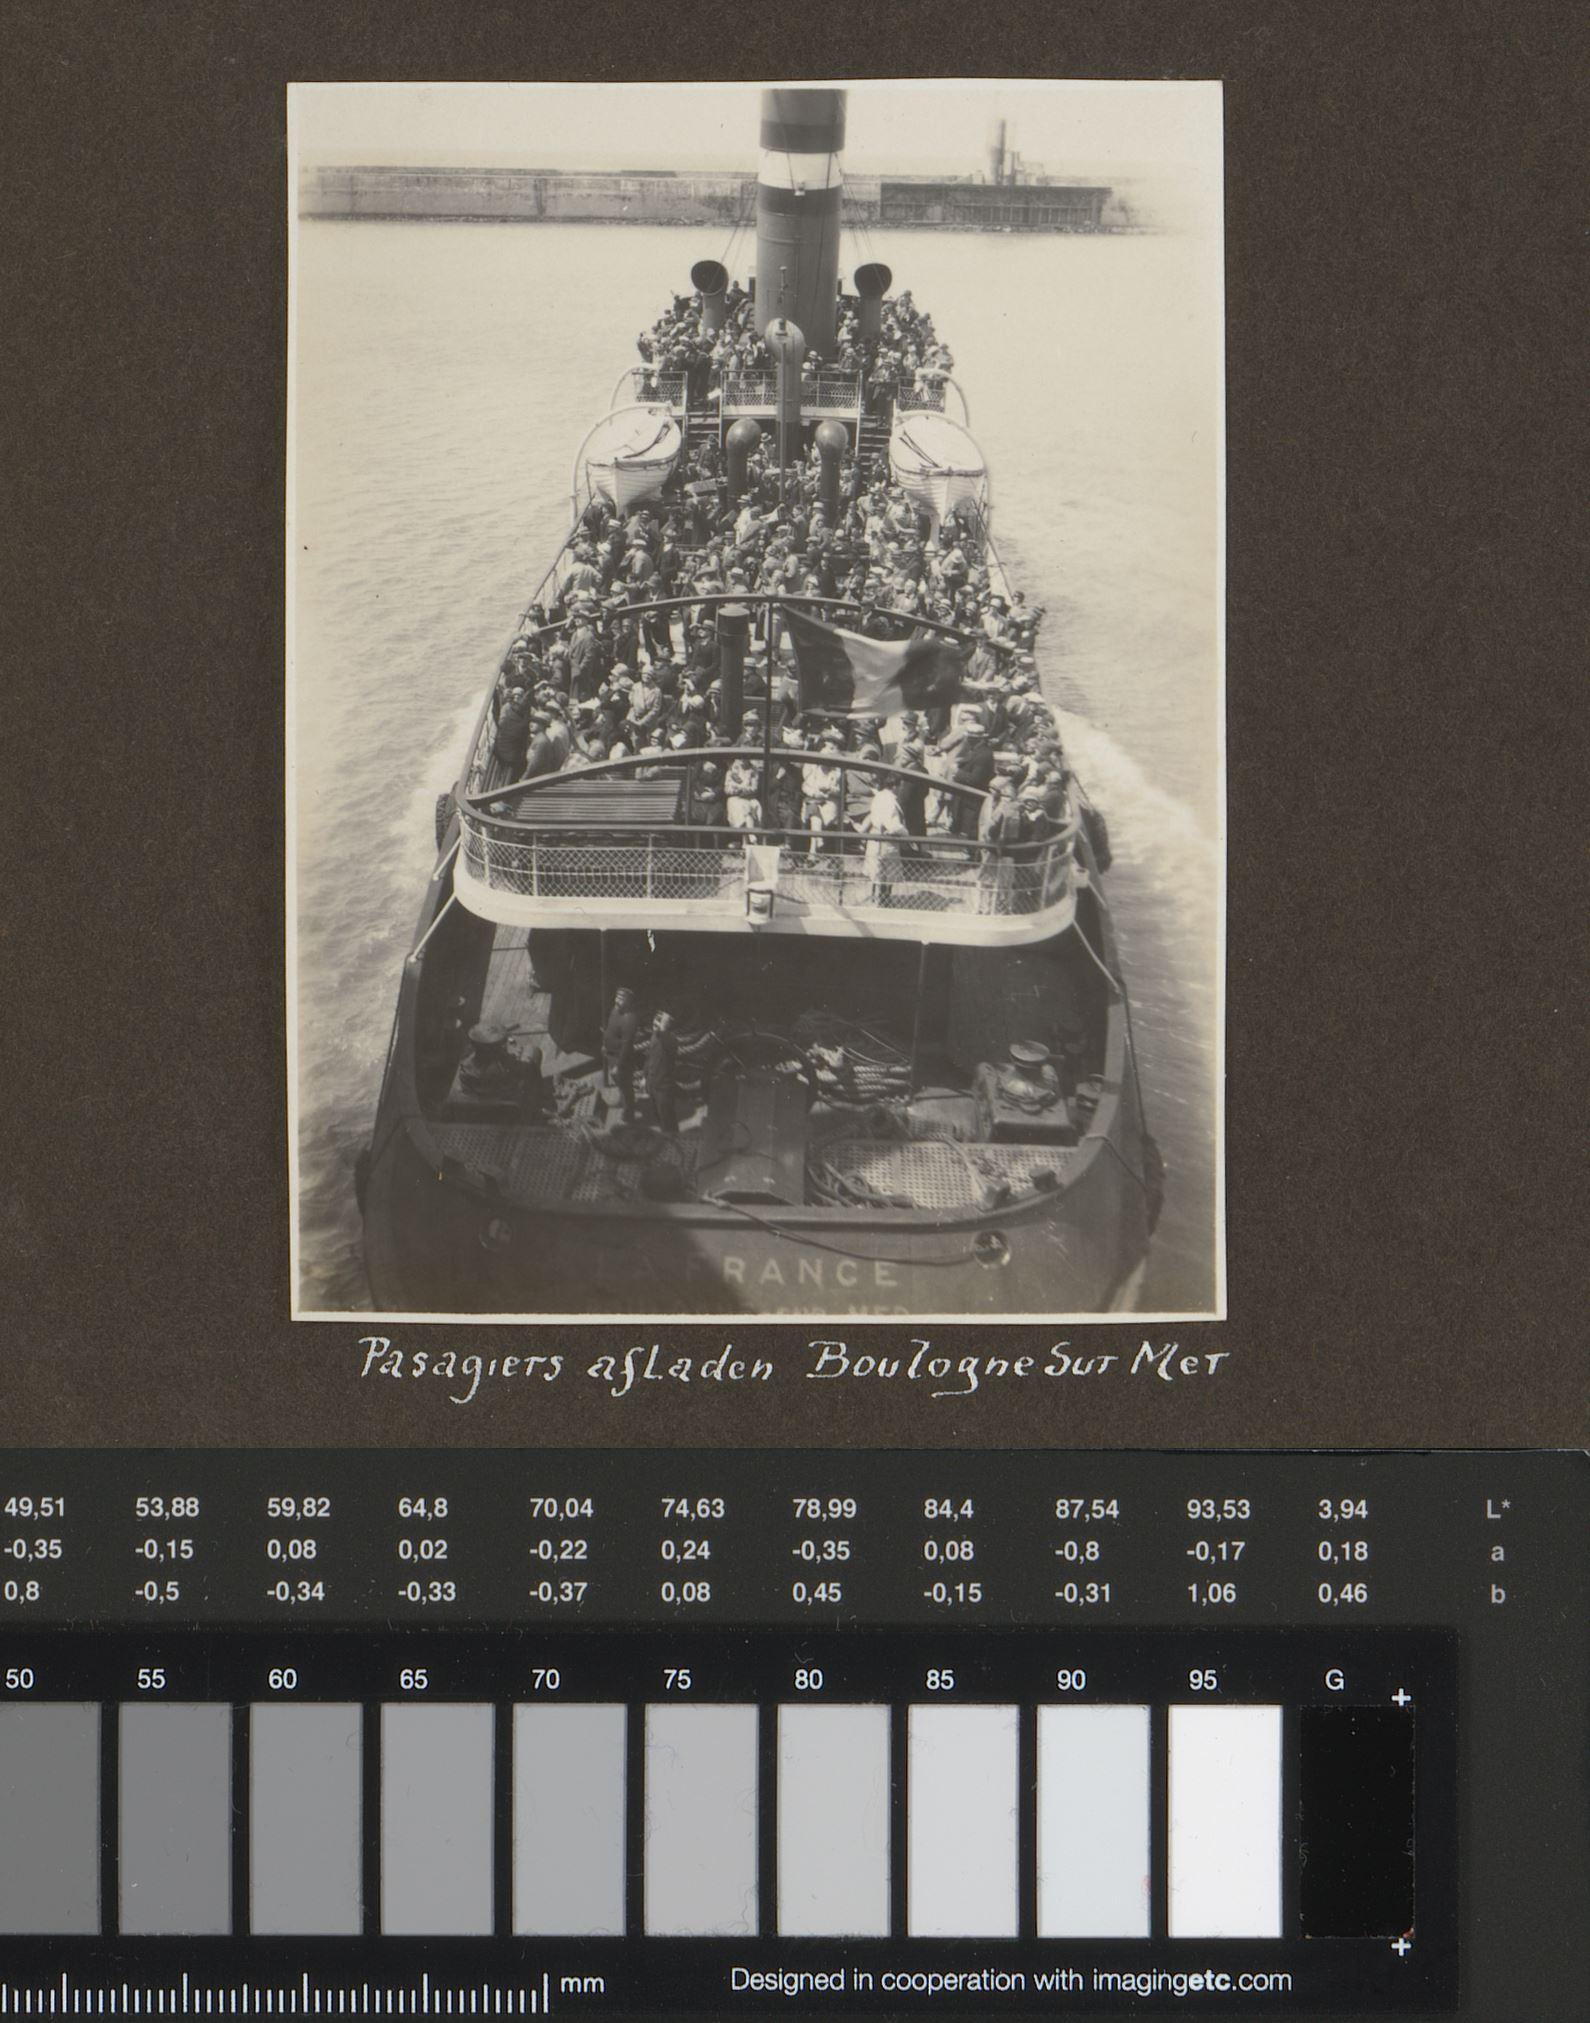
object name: photograph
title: Schip vol passagiers met op de achtergrond de haven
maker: Anonymous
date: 1928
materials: photographic support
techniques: gelatin silver print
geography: boulogne-sur-mer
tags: historical persons, ships (in general), sea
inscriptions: annotation: ‘Pasagiers afladen Boulogne Sur Mer’